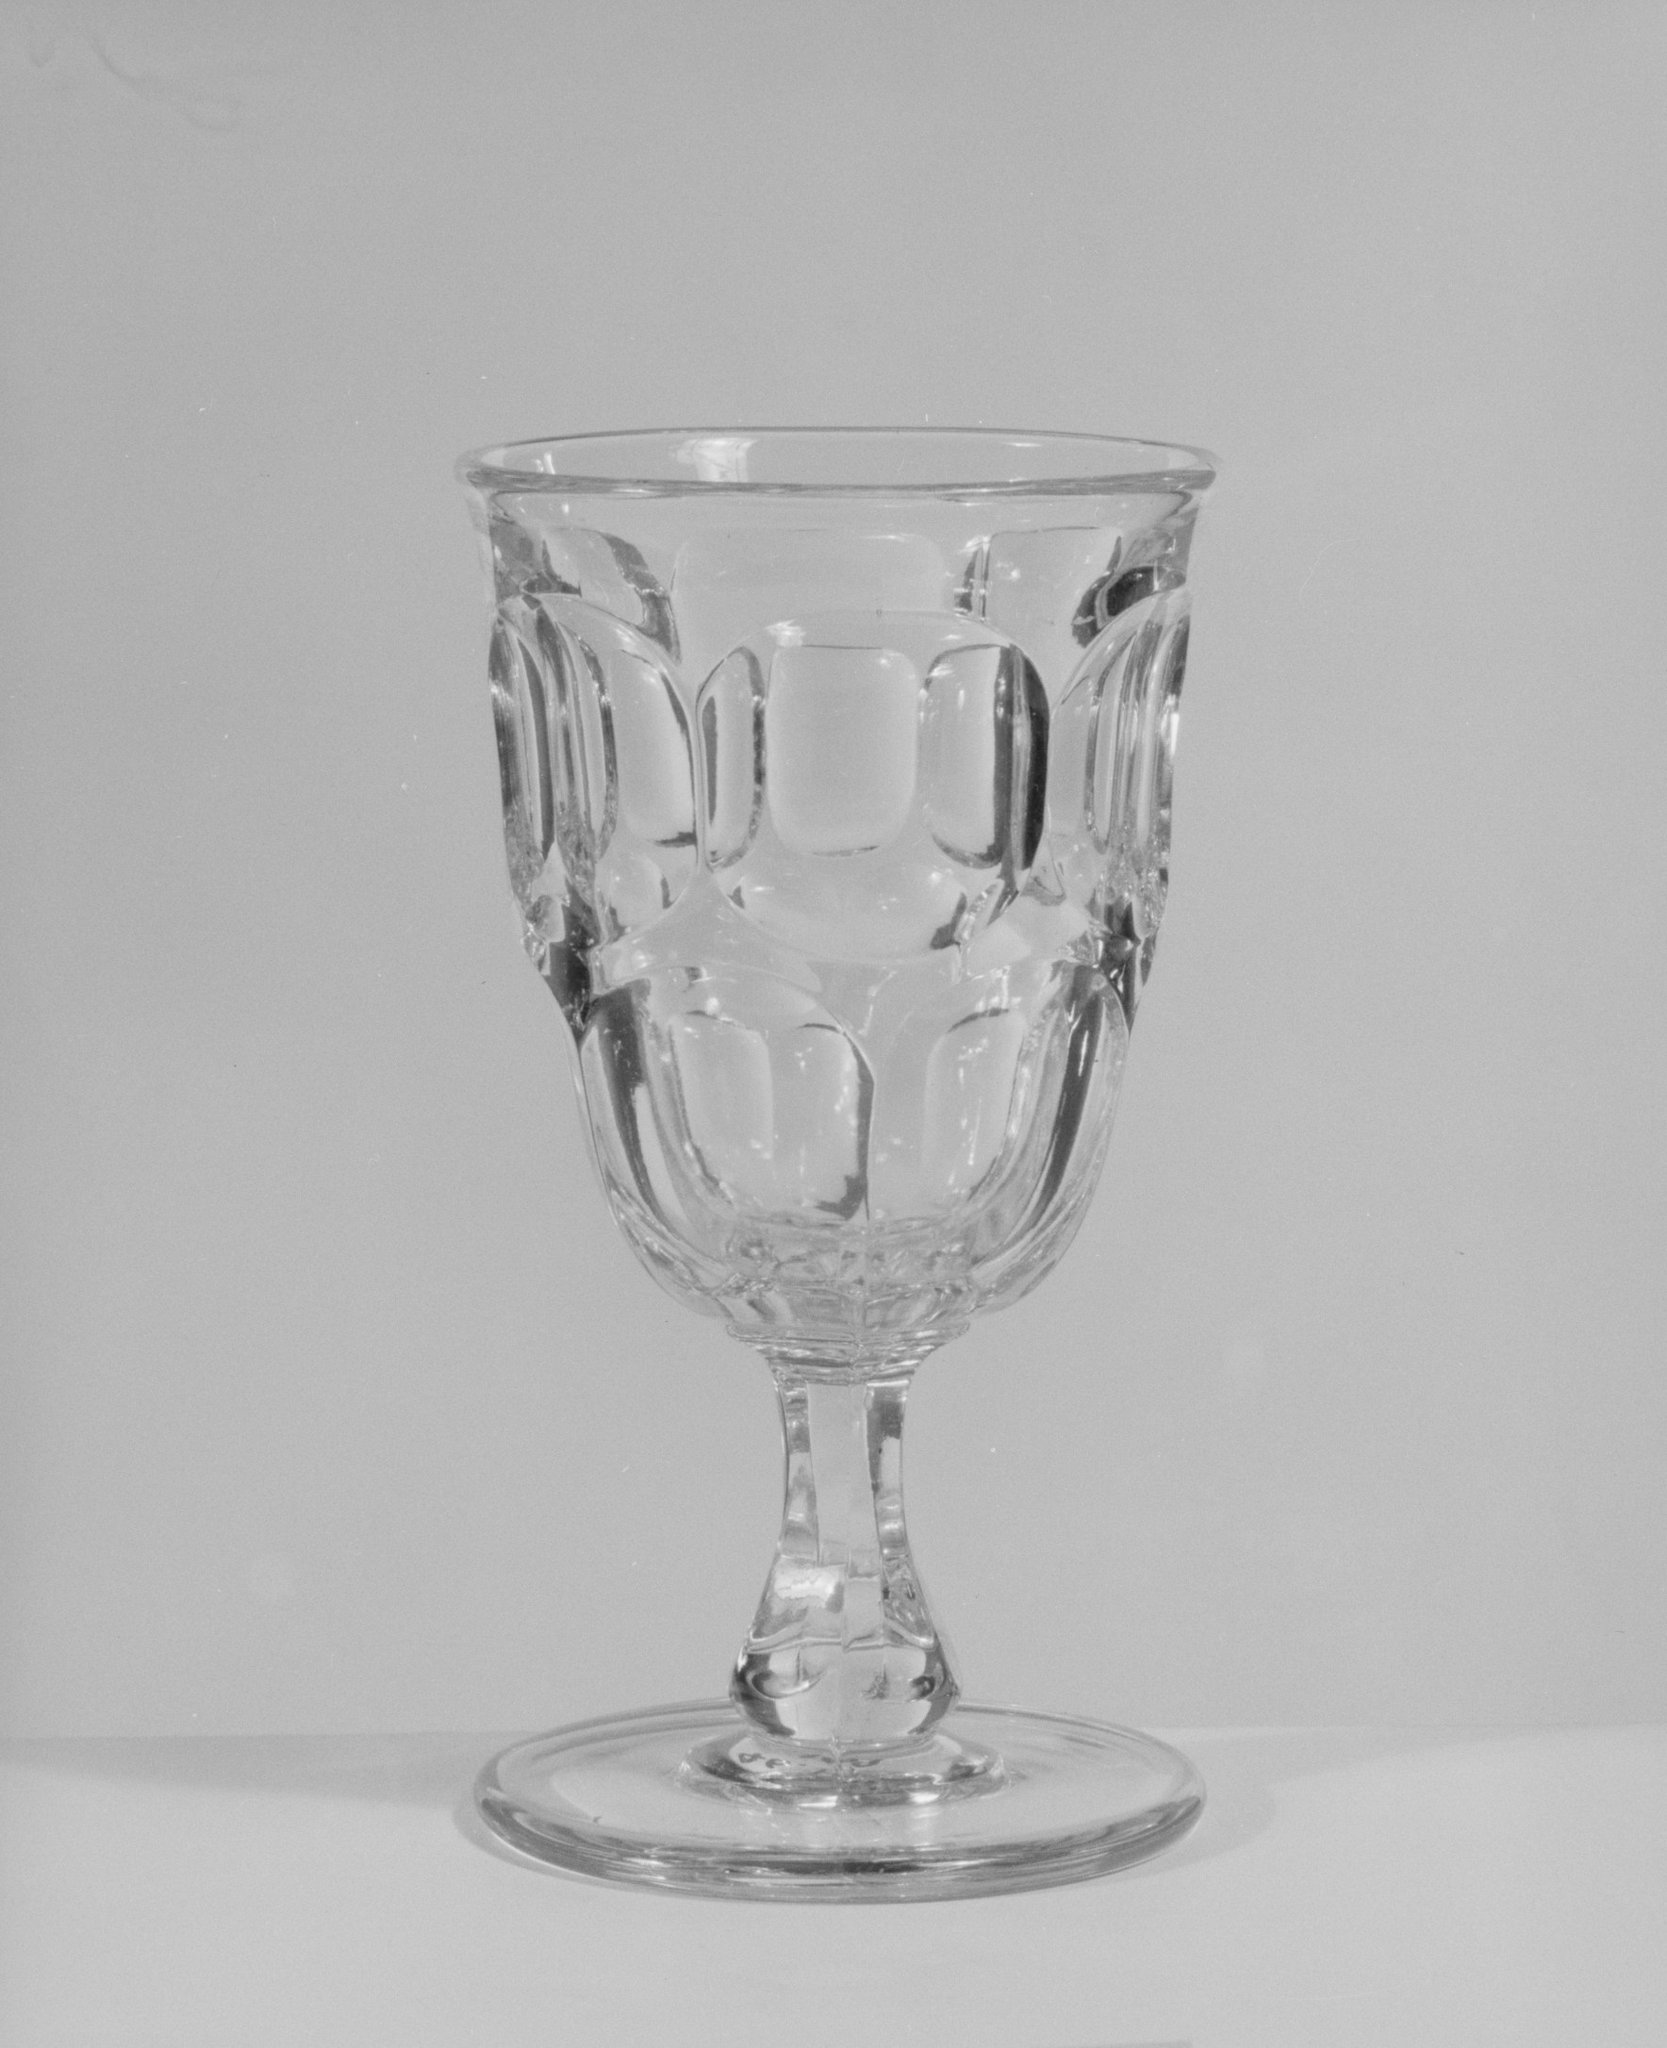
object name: goblet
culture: american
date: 1830-1870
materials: glass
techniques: pressed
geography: united states